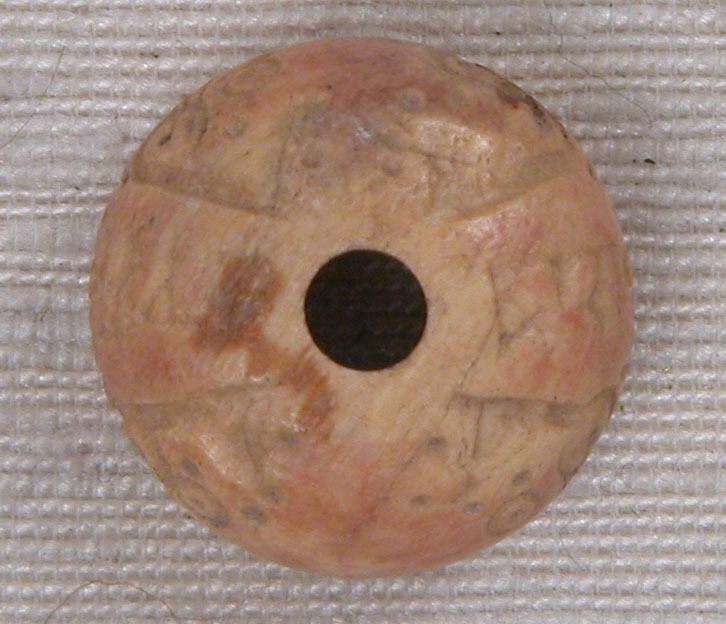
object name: button or bead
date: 801-1000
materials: bone, paint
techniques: incising, inlay, tinting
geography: iran